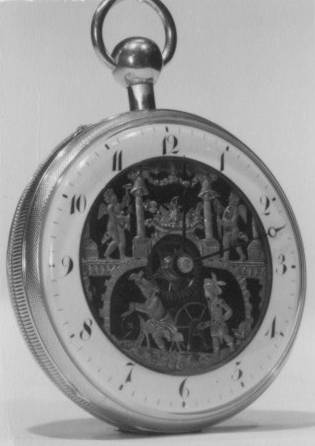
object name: music box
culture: swiss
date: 1820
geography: switzerland